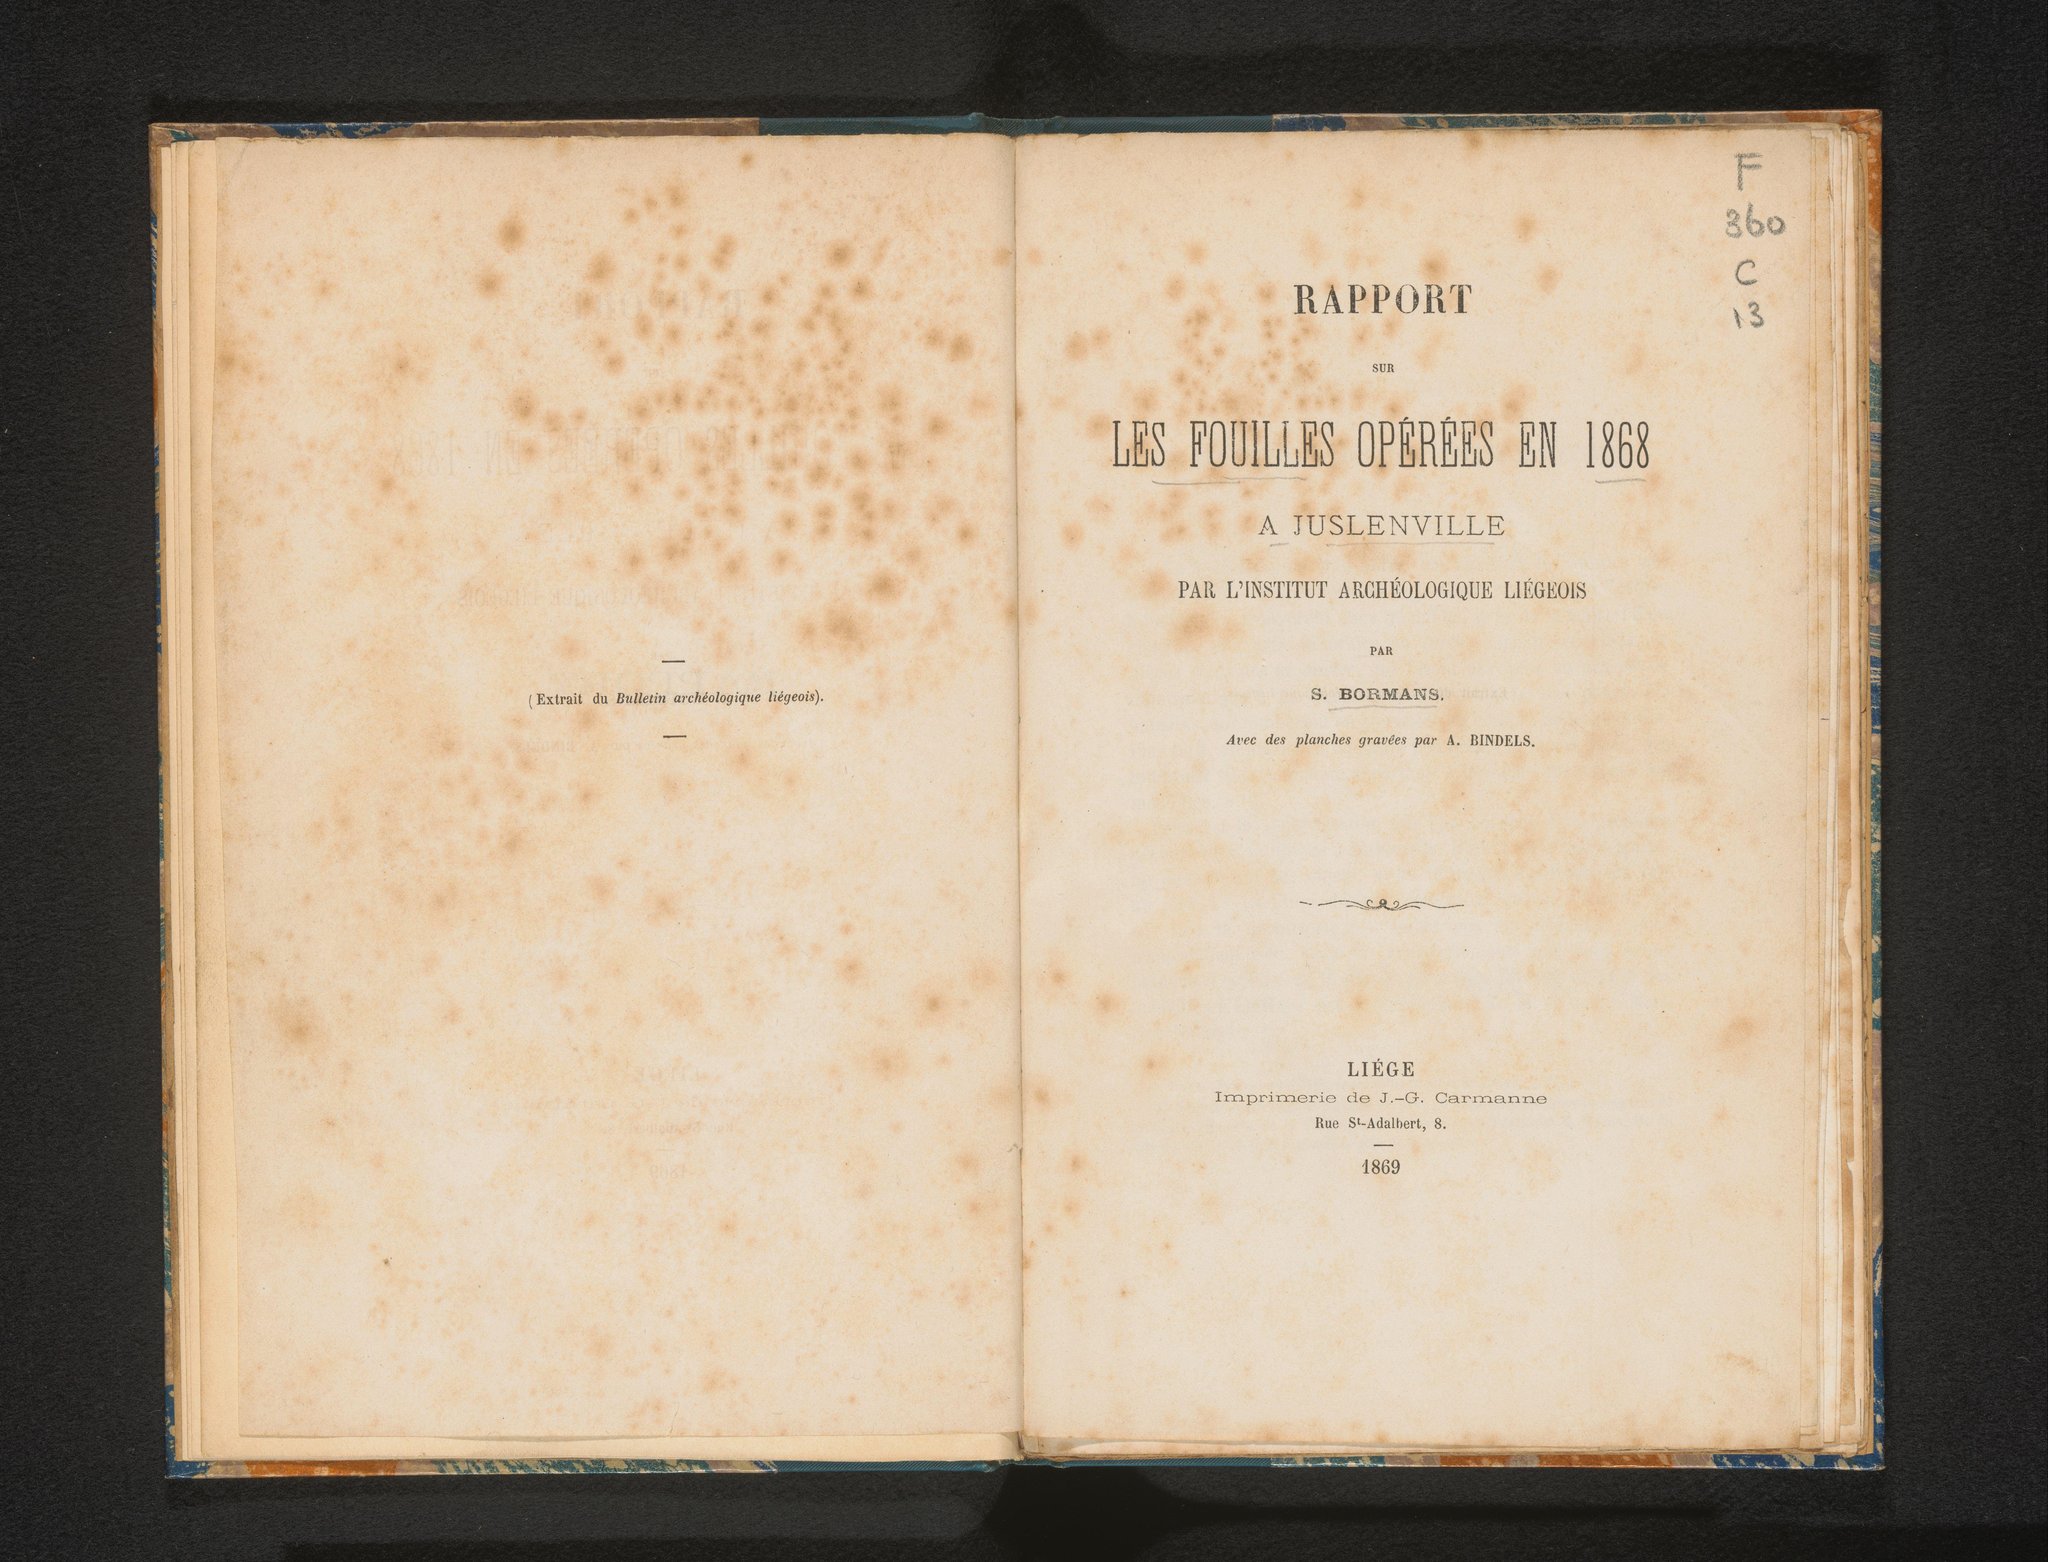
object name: book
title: Rapport sur les fouilles opérées en 1868 à Juslenville par l'Institut archéologique Liégeois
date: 1869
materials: cardboard, paper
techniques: albumen print, lithograph, printing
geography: liège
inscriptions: annotation: ‘APR/ 1998’